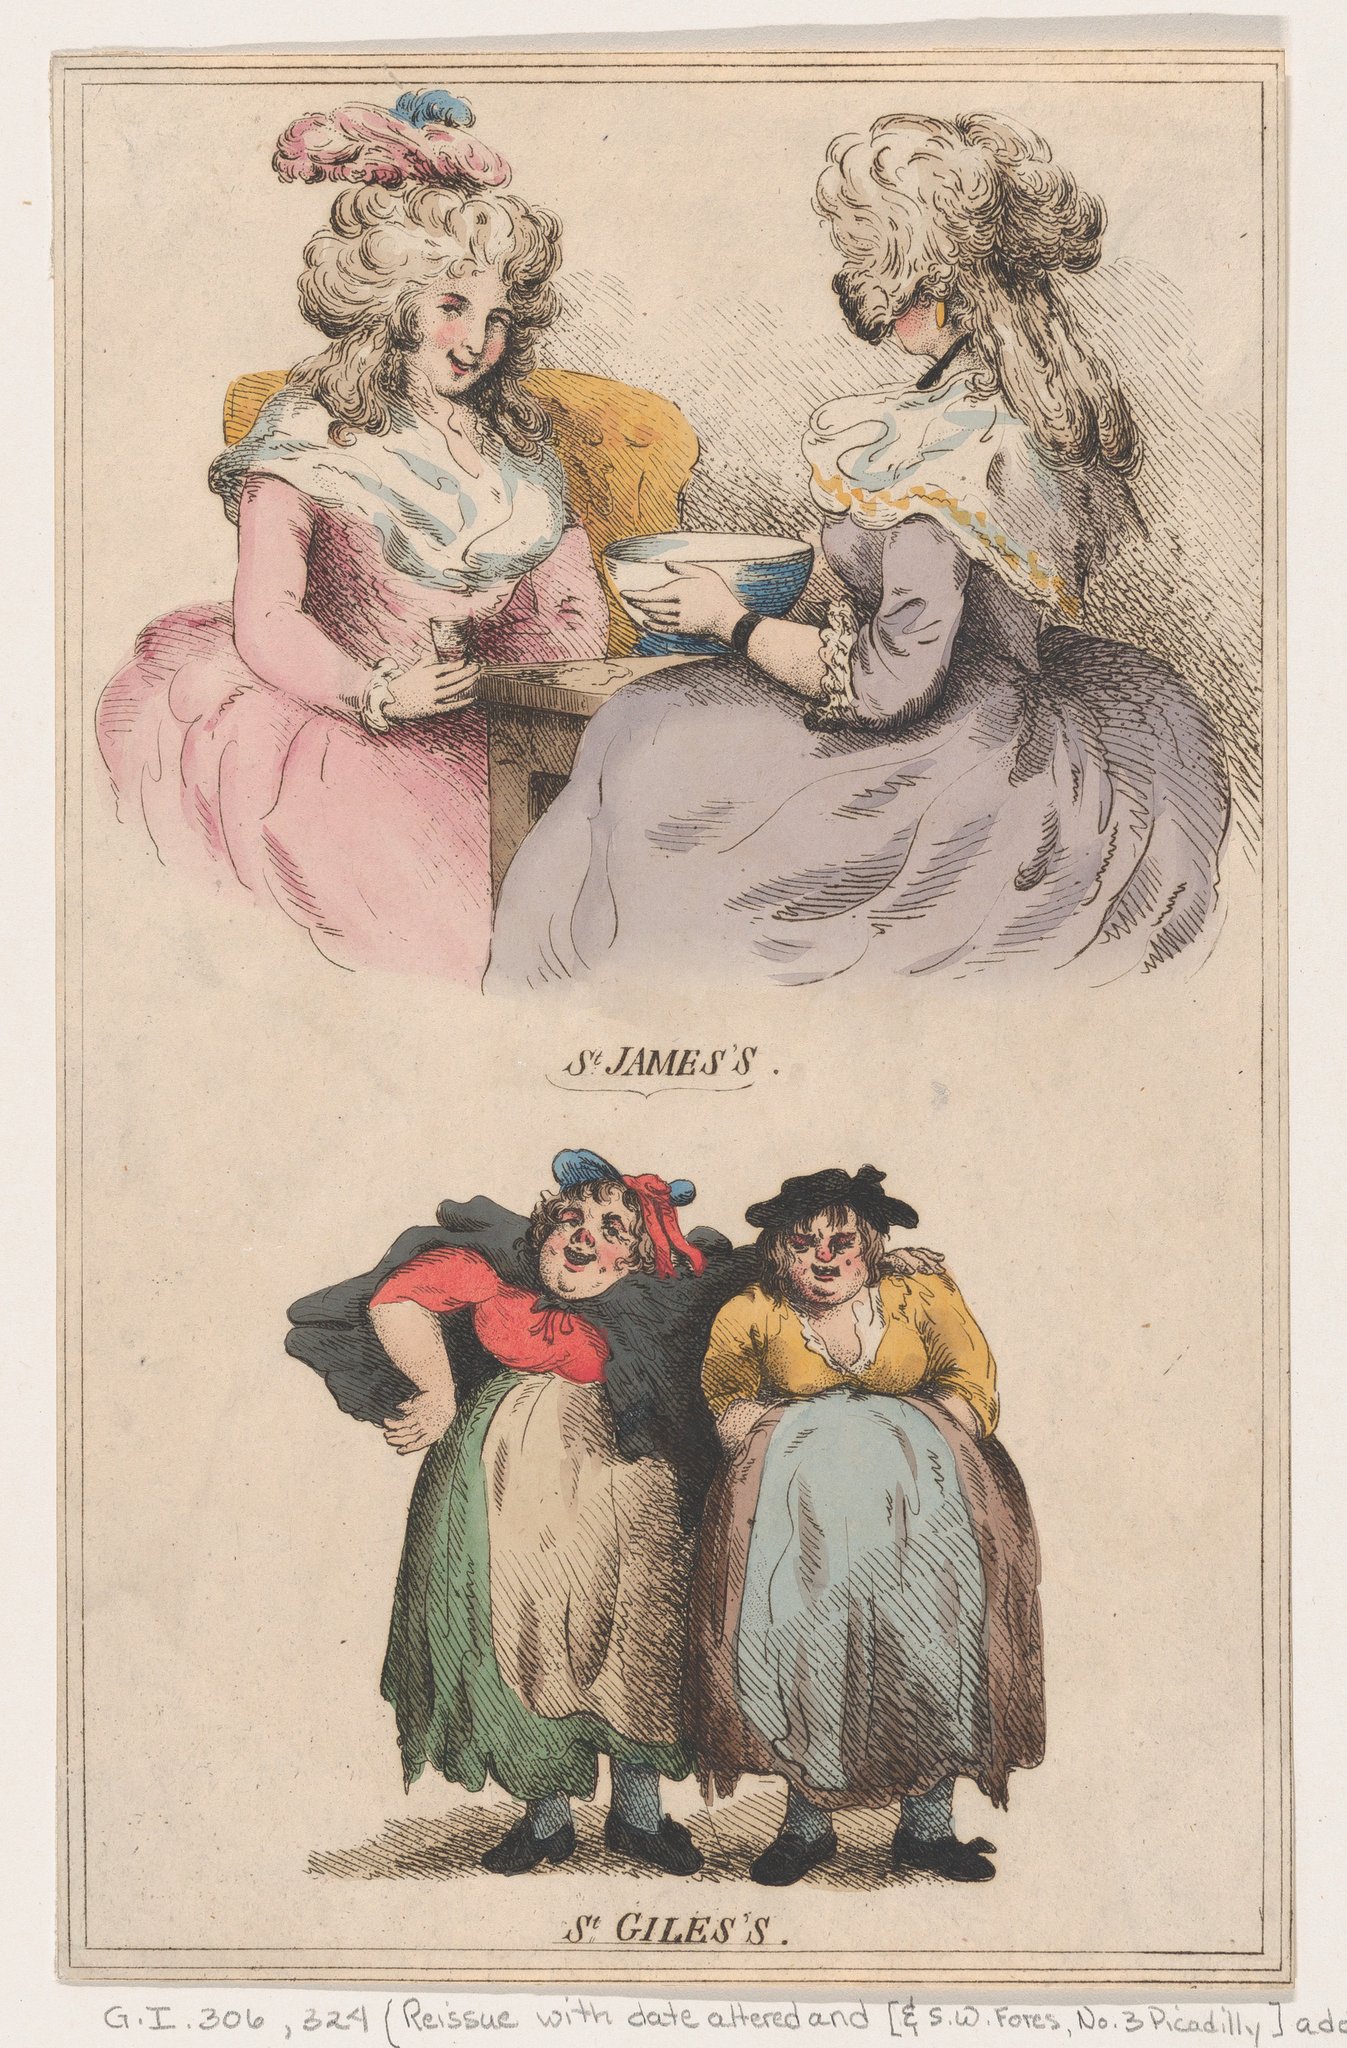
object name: print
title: St. James's and St. Giles's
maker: thomas rowlandson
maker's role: artist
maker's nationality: british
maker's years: 1757-1827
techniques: etching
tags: satire,women